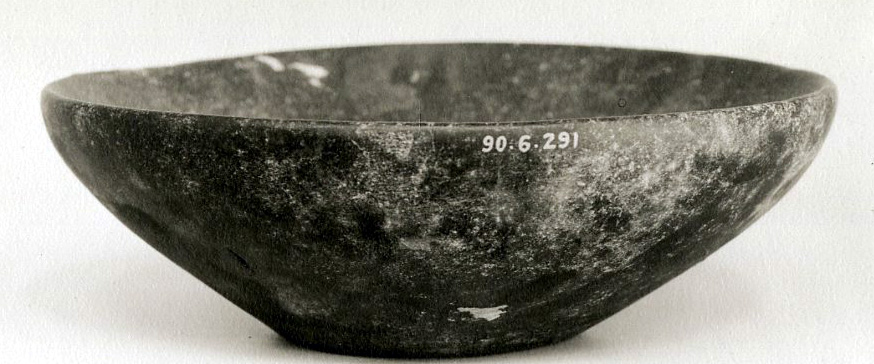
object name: bowl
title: Shallow bowl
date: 3100-2649 BCE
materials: stone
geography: egypt